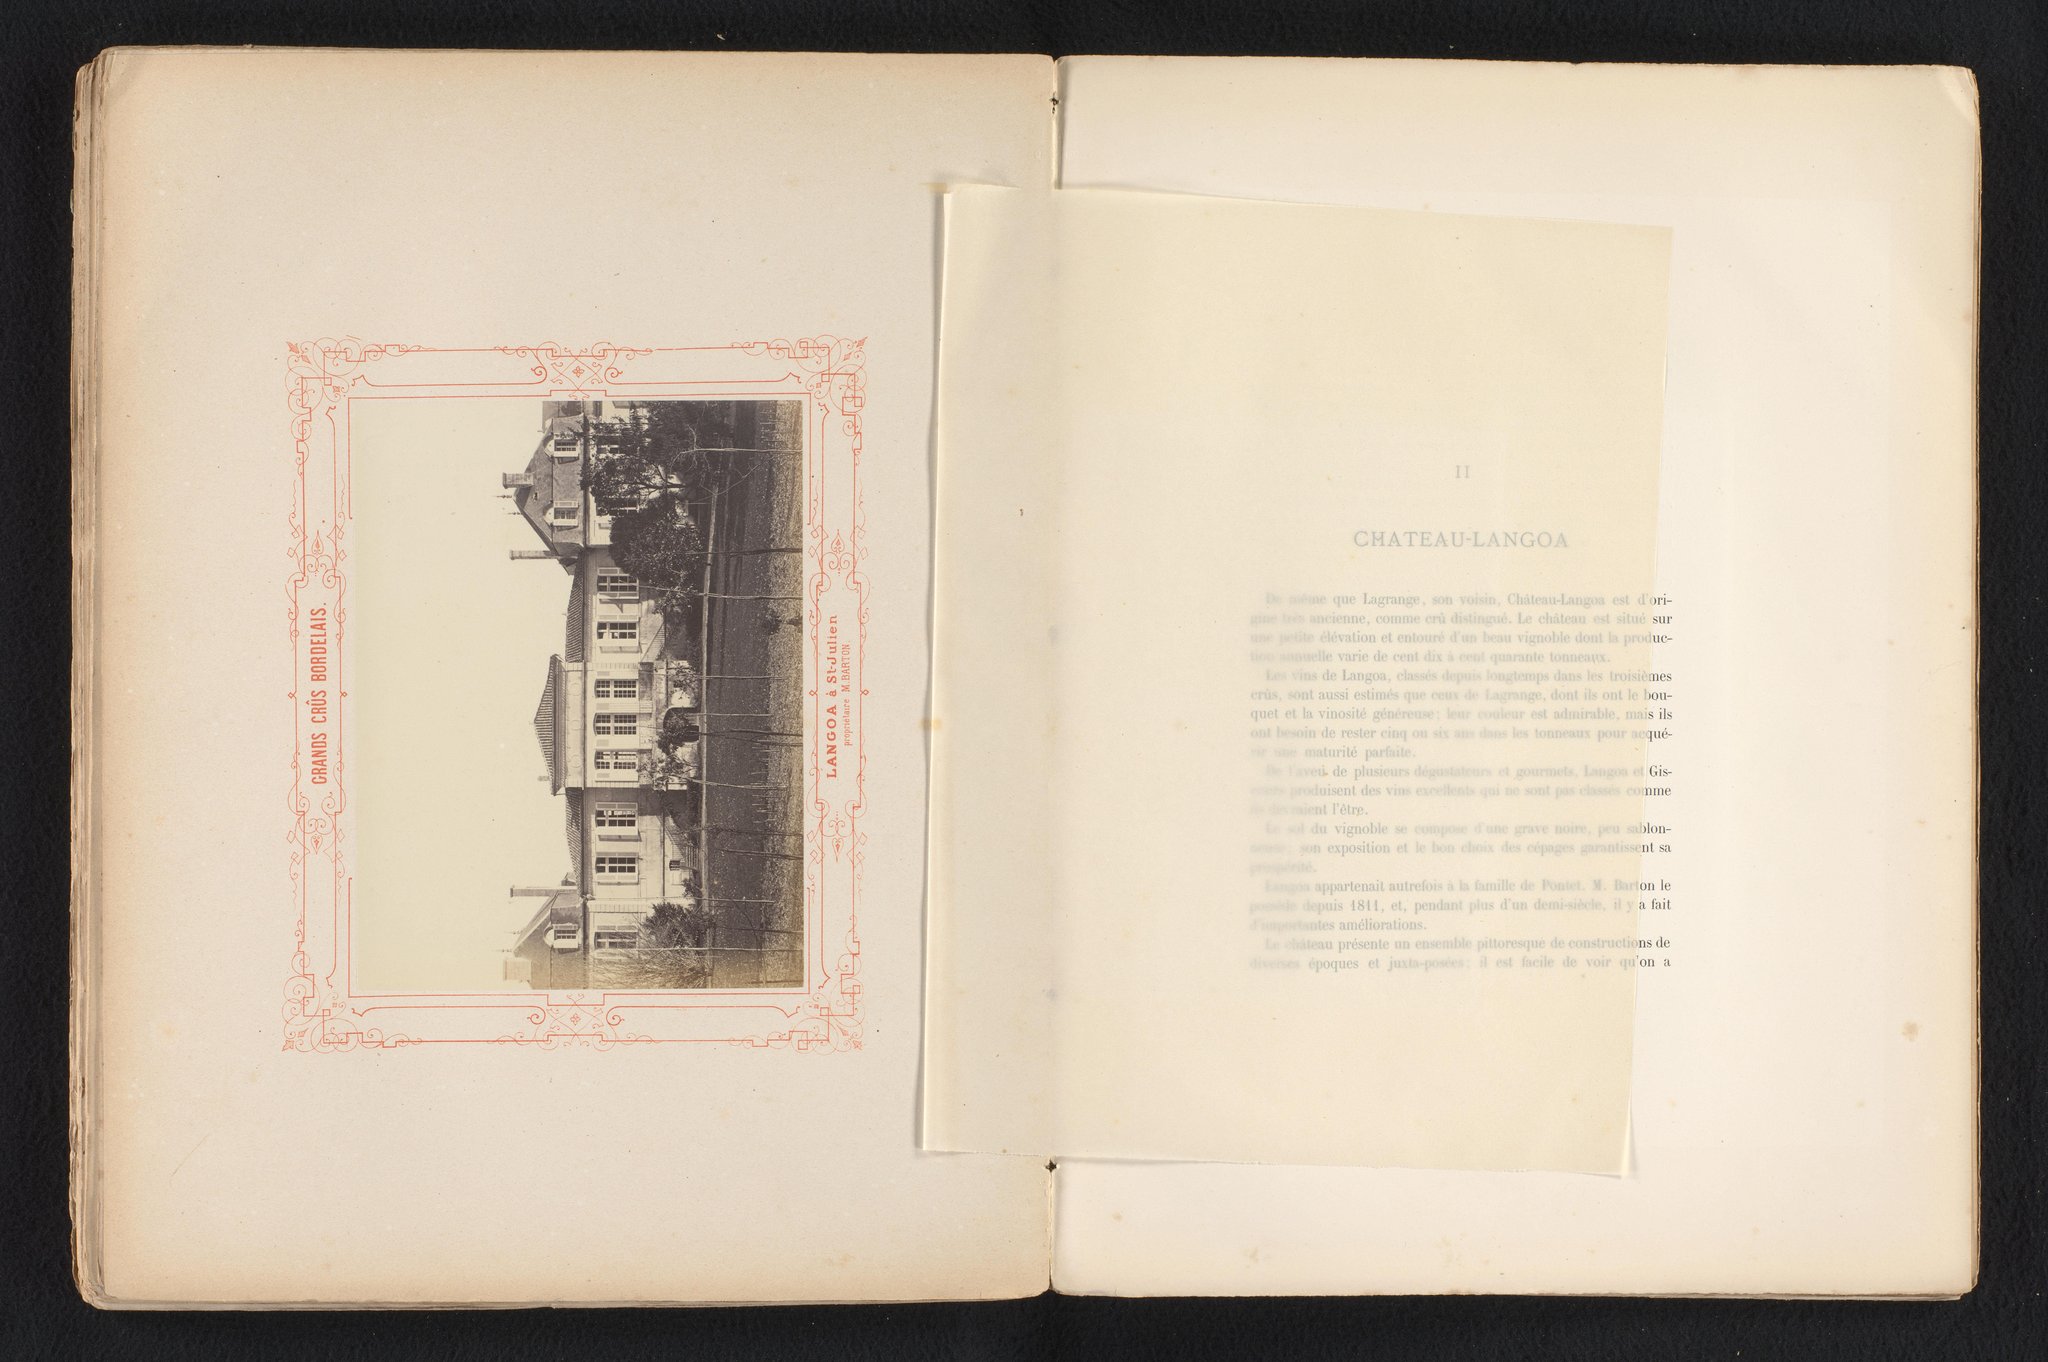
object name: page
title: Grands crûs Bordelais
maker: alfred danflou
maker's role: fotograaf, schrijver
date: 1862-1867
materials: paper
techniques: albumen print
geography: saint-julien-beychevelle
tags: castle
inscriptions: inscription: ‘propriétaire: M. BARTON.’